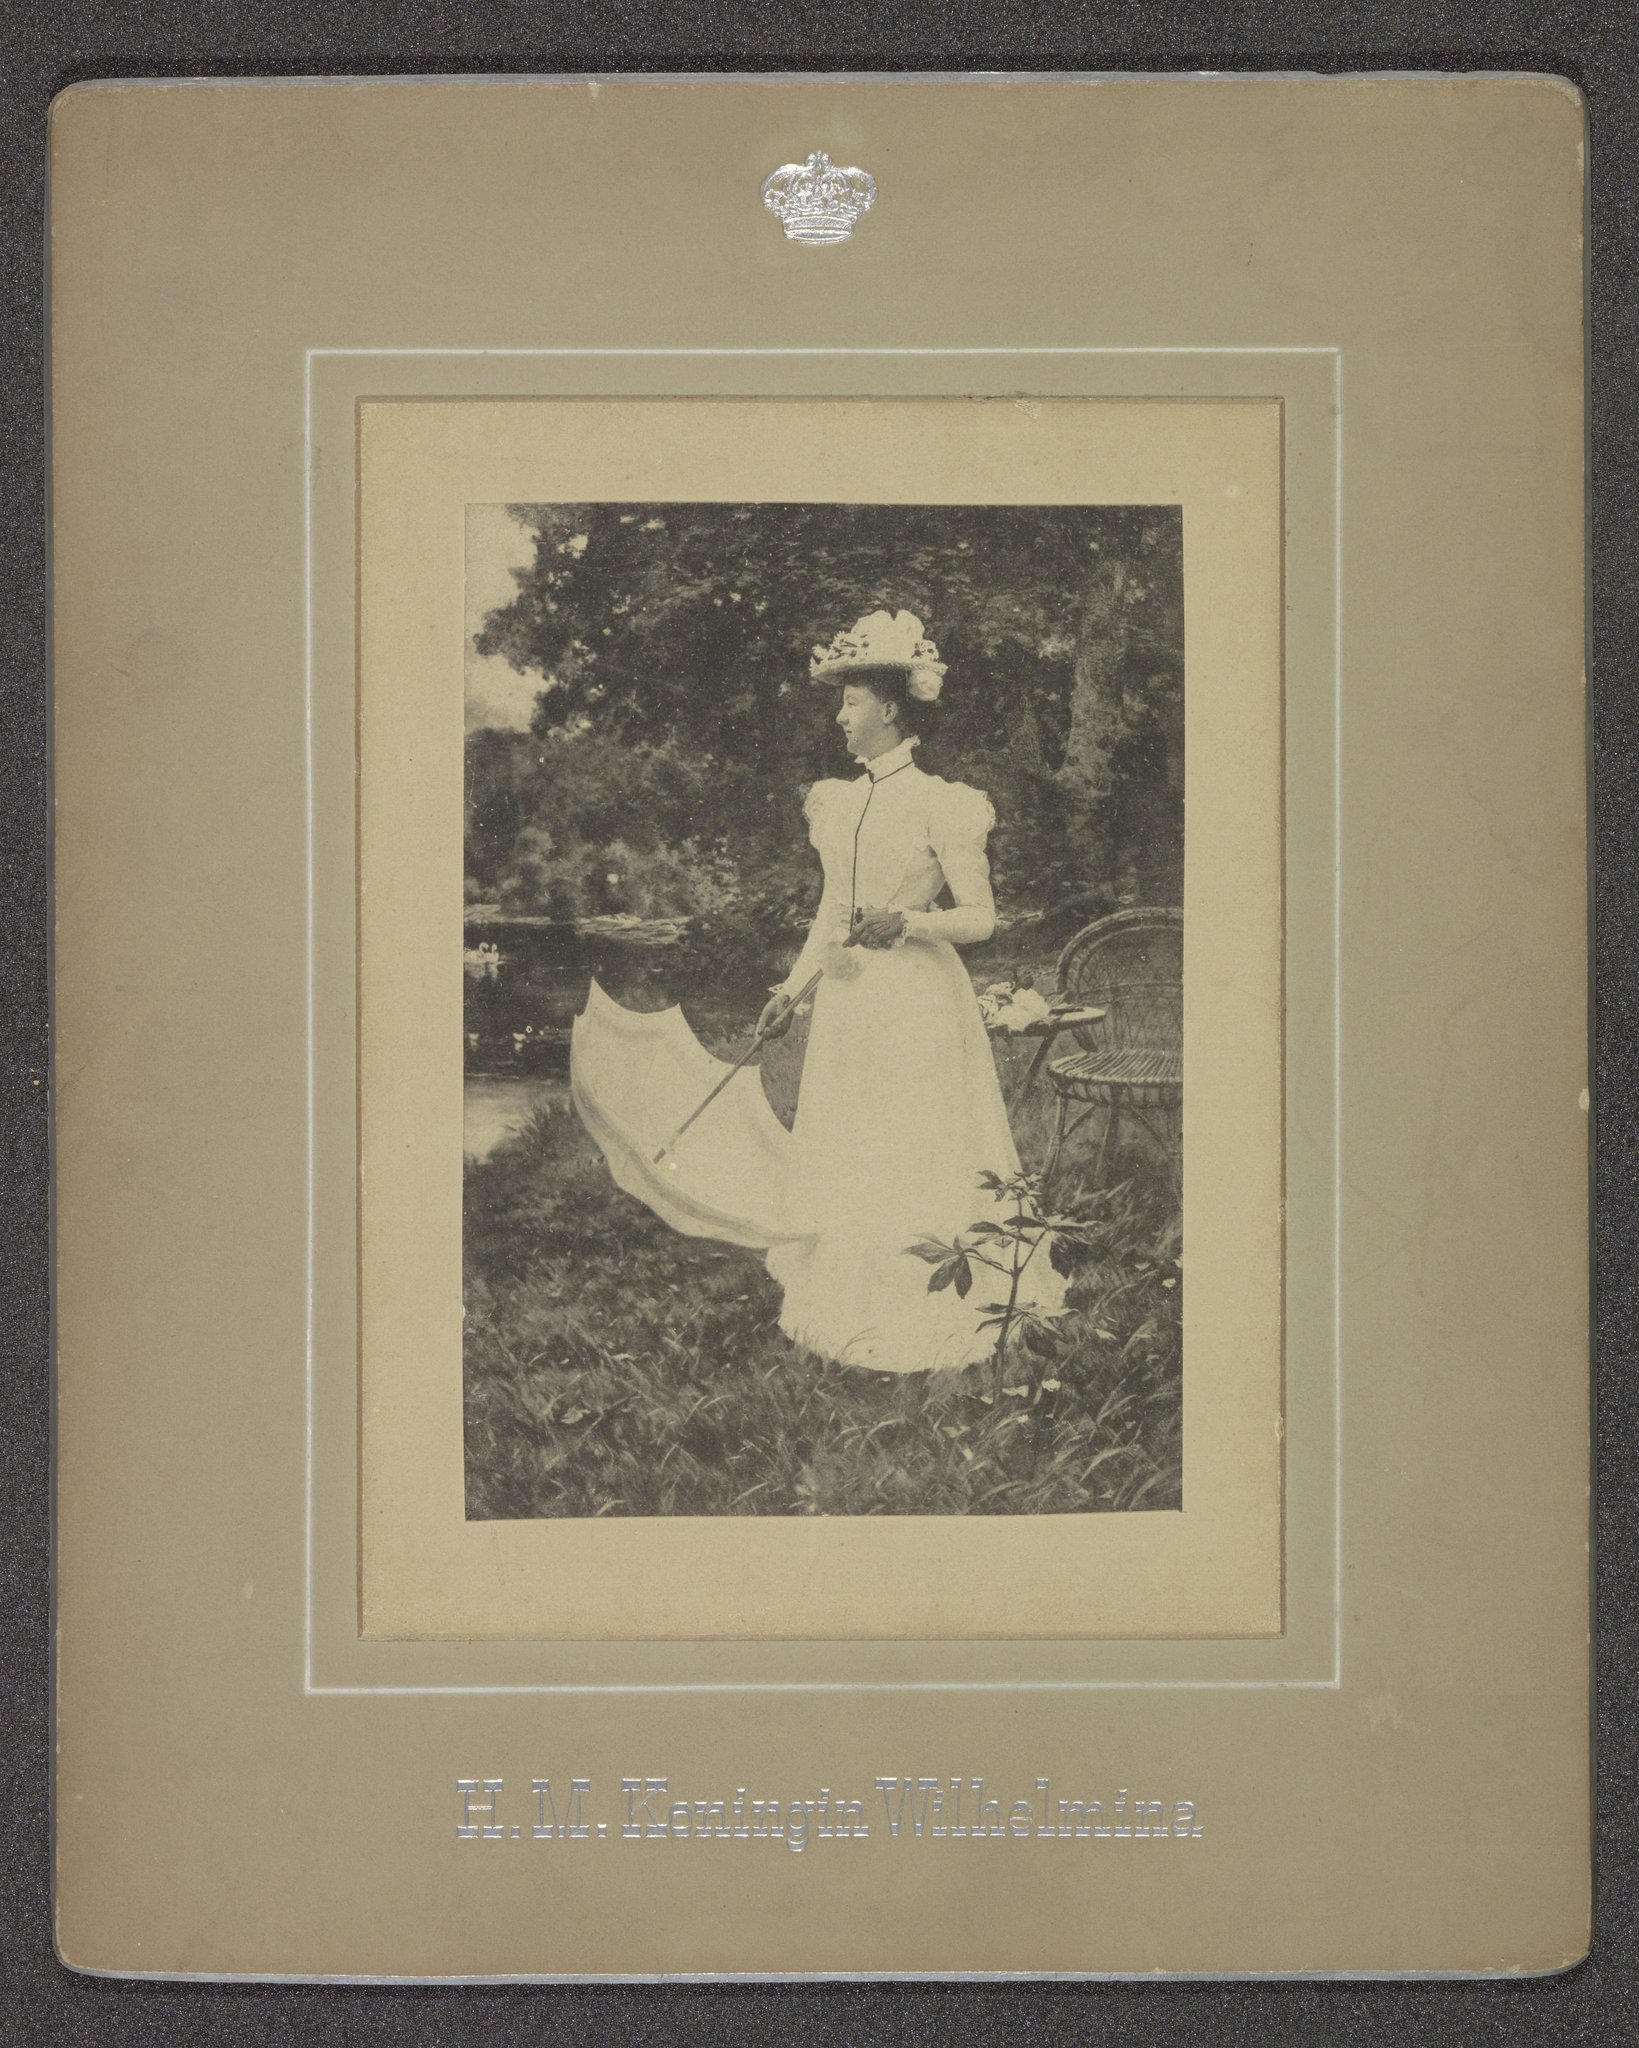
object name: photograph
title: H.M. Koningin Wilhelmina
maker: Anonymous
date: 1898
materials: cardboard, paper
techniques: photoaquatint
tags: wilhelmina of the netherlands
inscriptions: inscription: ‘Soesdijk 16-7-1898, 75C’